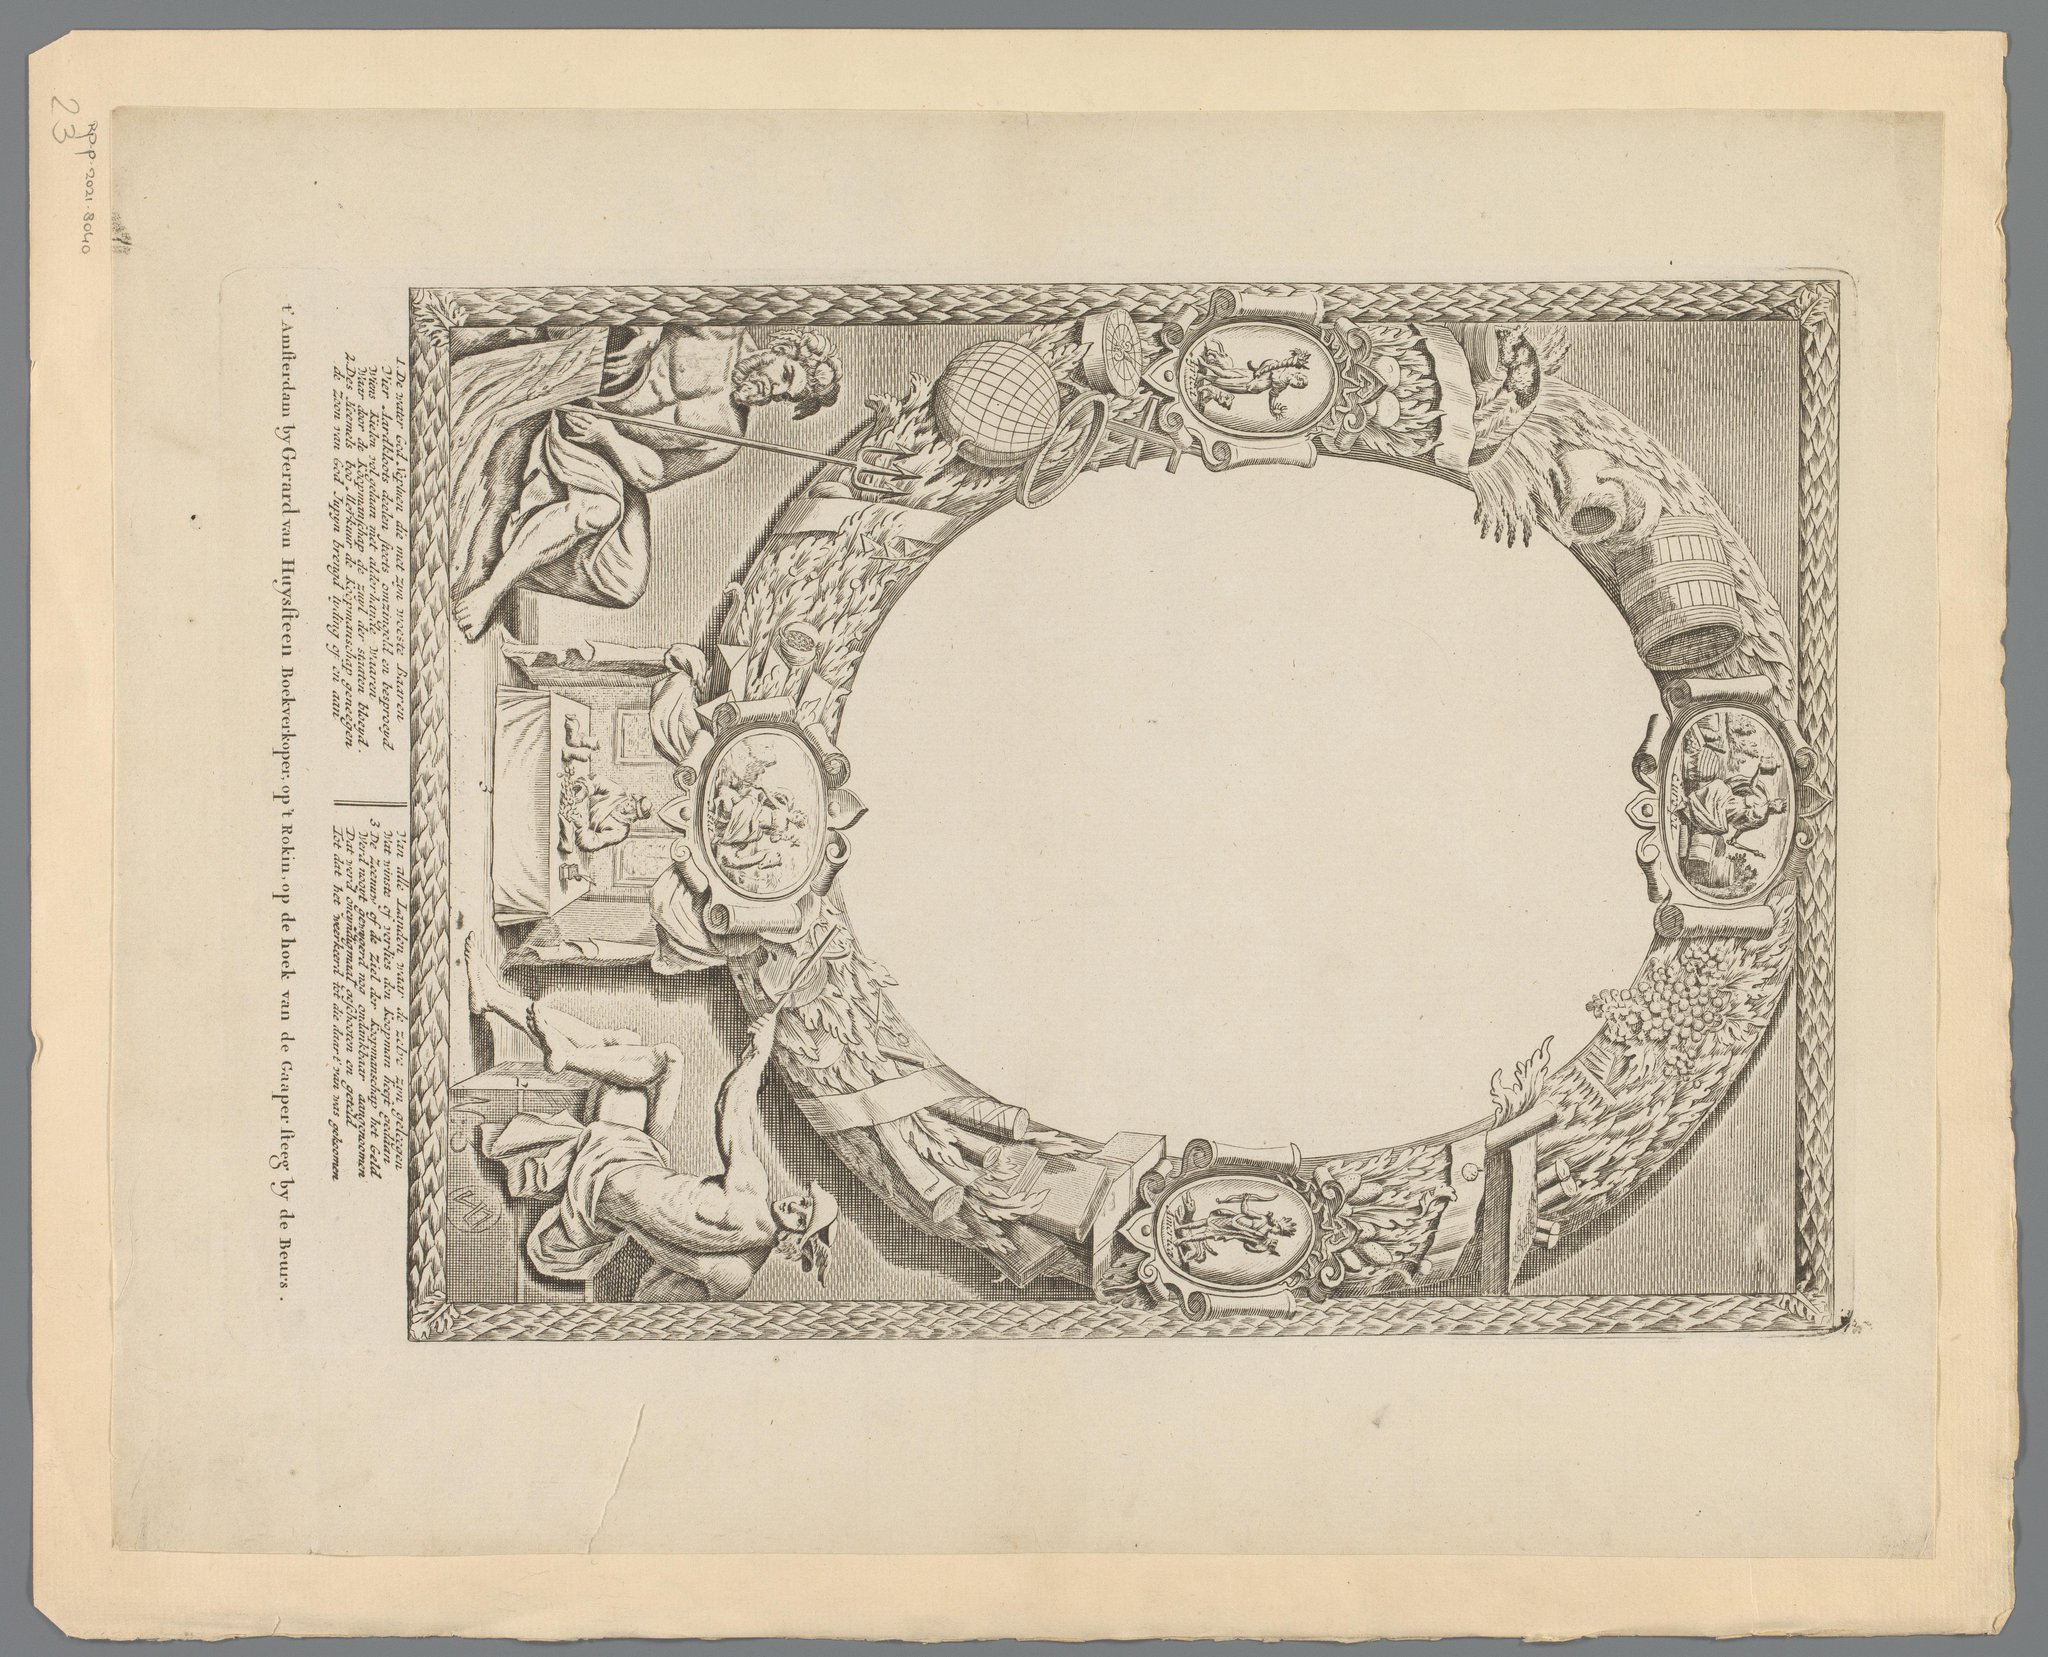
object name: print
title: Allegorie op de handel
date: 1754-1759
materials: paper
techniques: engraving, etching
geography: rokin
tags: (story of) neptune (poseidon), (story of) mercury (hermes), allegory of trade; 'commertio della vita humana' (ripa)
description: Lauwerkrans met daarin objecten die te maken hebben met handel, en vier medaillons met in elk ervan een werelddeel verbeeld door een personificatie. Daaronder links Neptunus en rechts Mercurius en in het midden een munten tellende koopman. Een onderschrift legt deze figuren uit in de context van de prent.